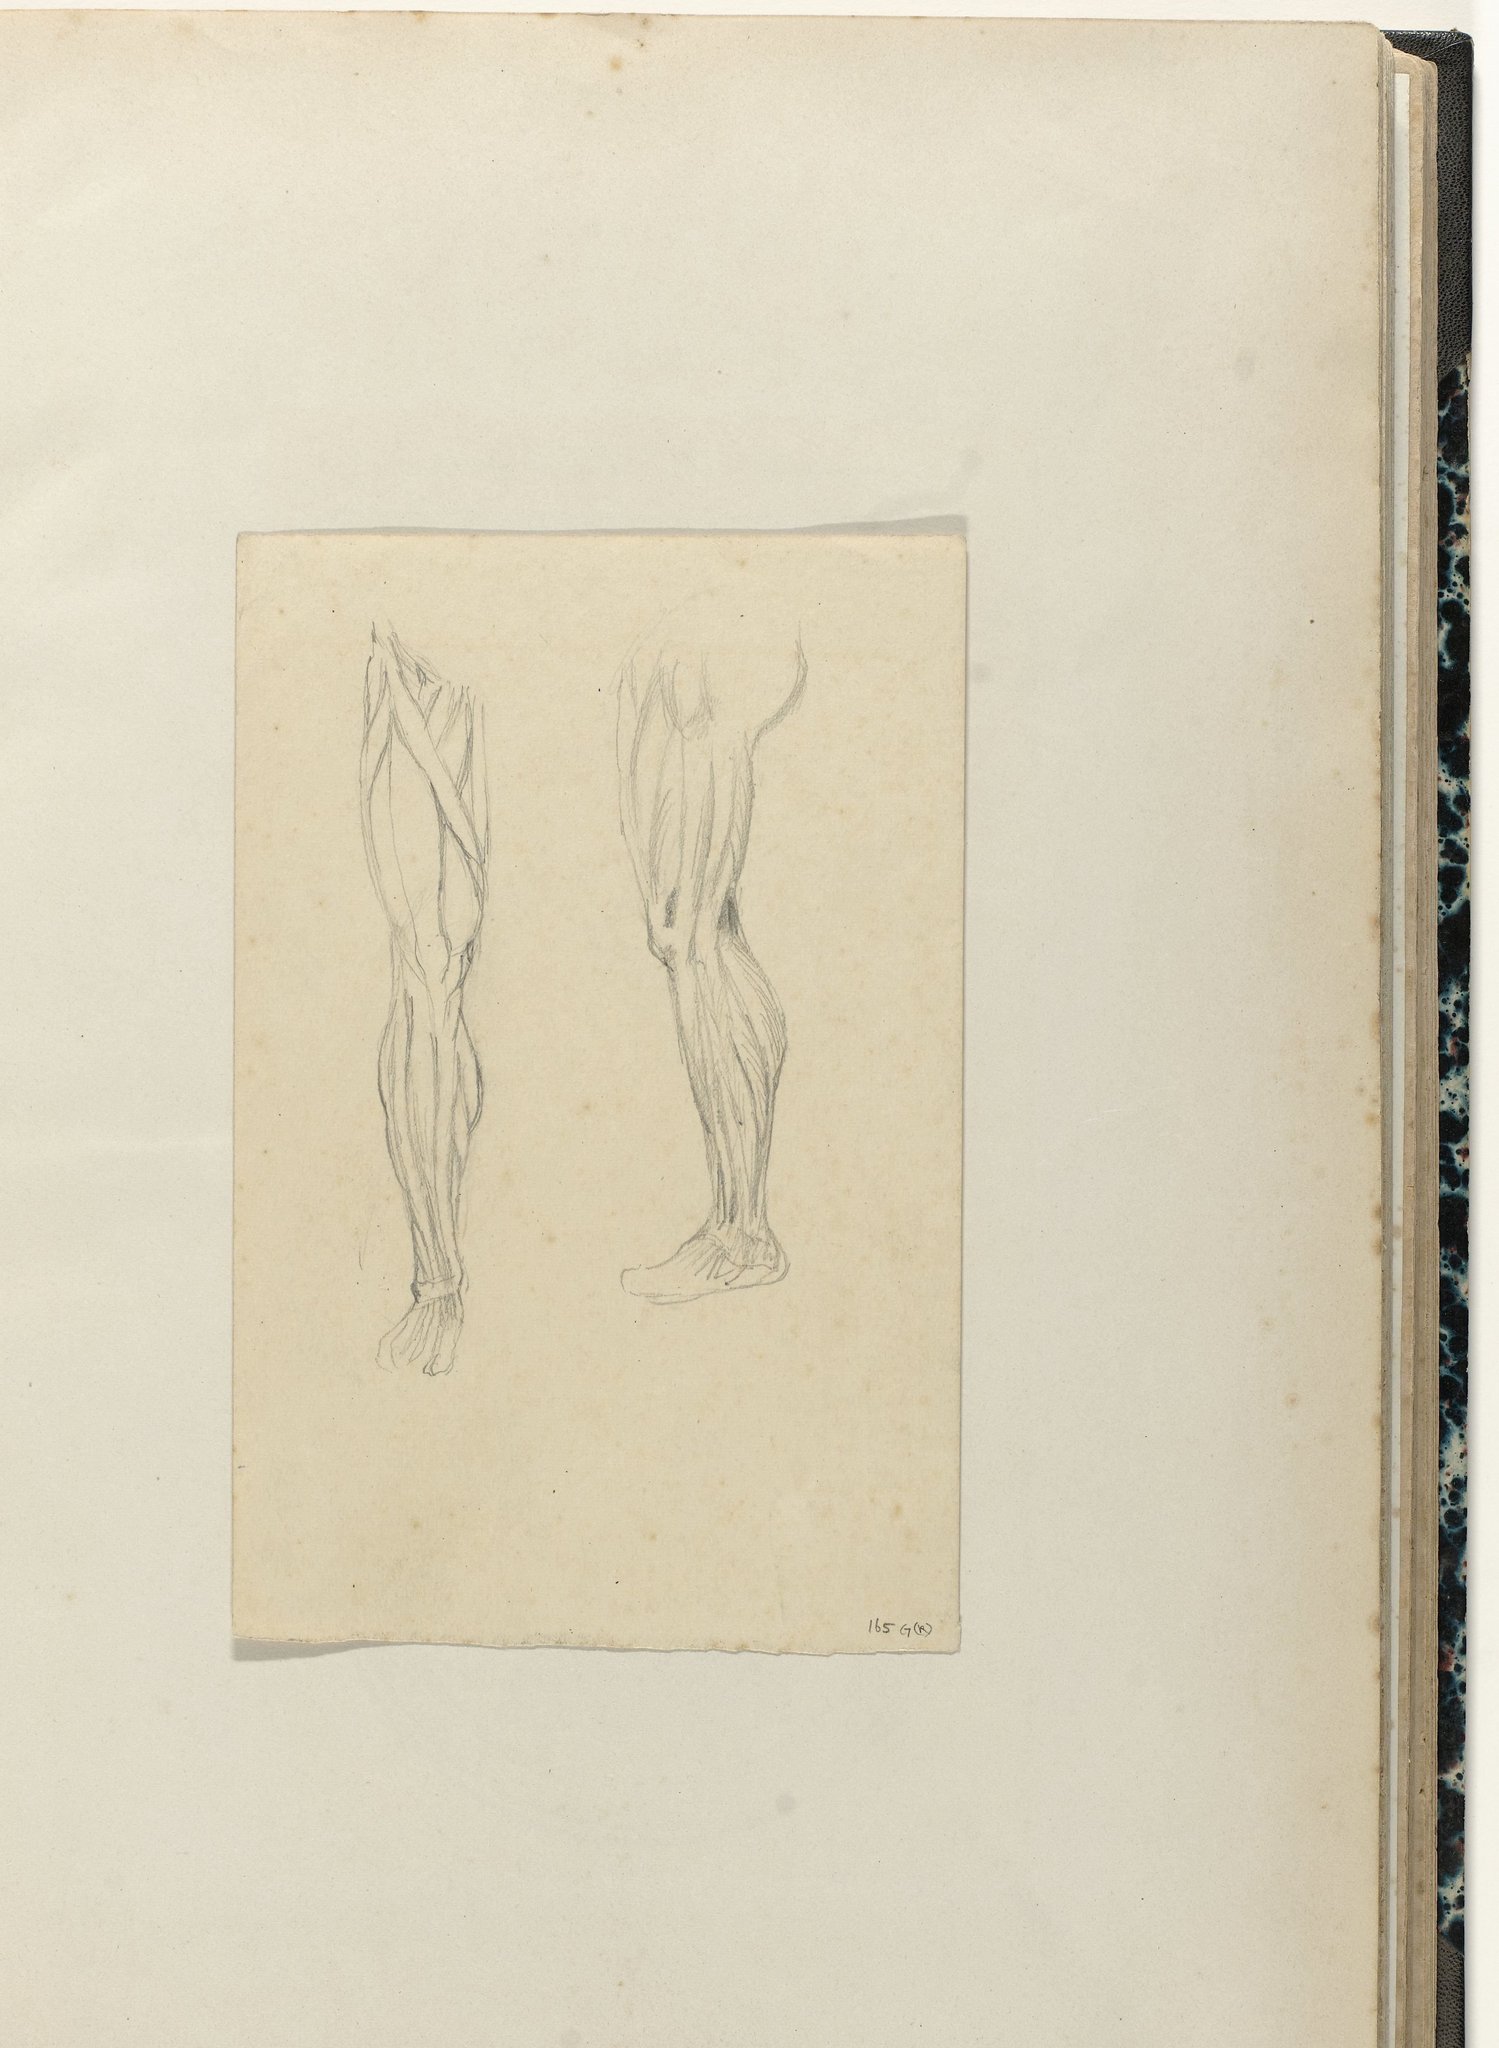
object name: drawing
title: Twee studies van een been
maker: Anonymous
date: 1866-1900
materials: paper, pencil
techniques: drawing